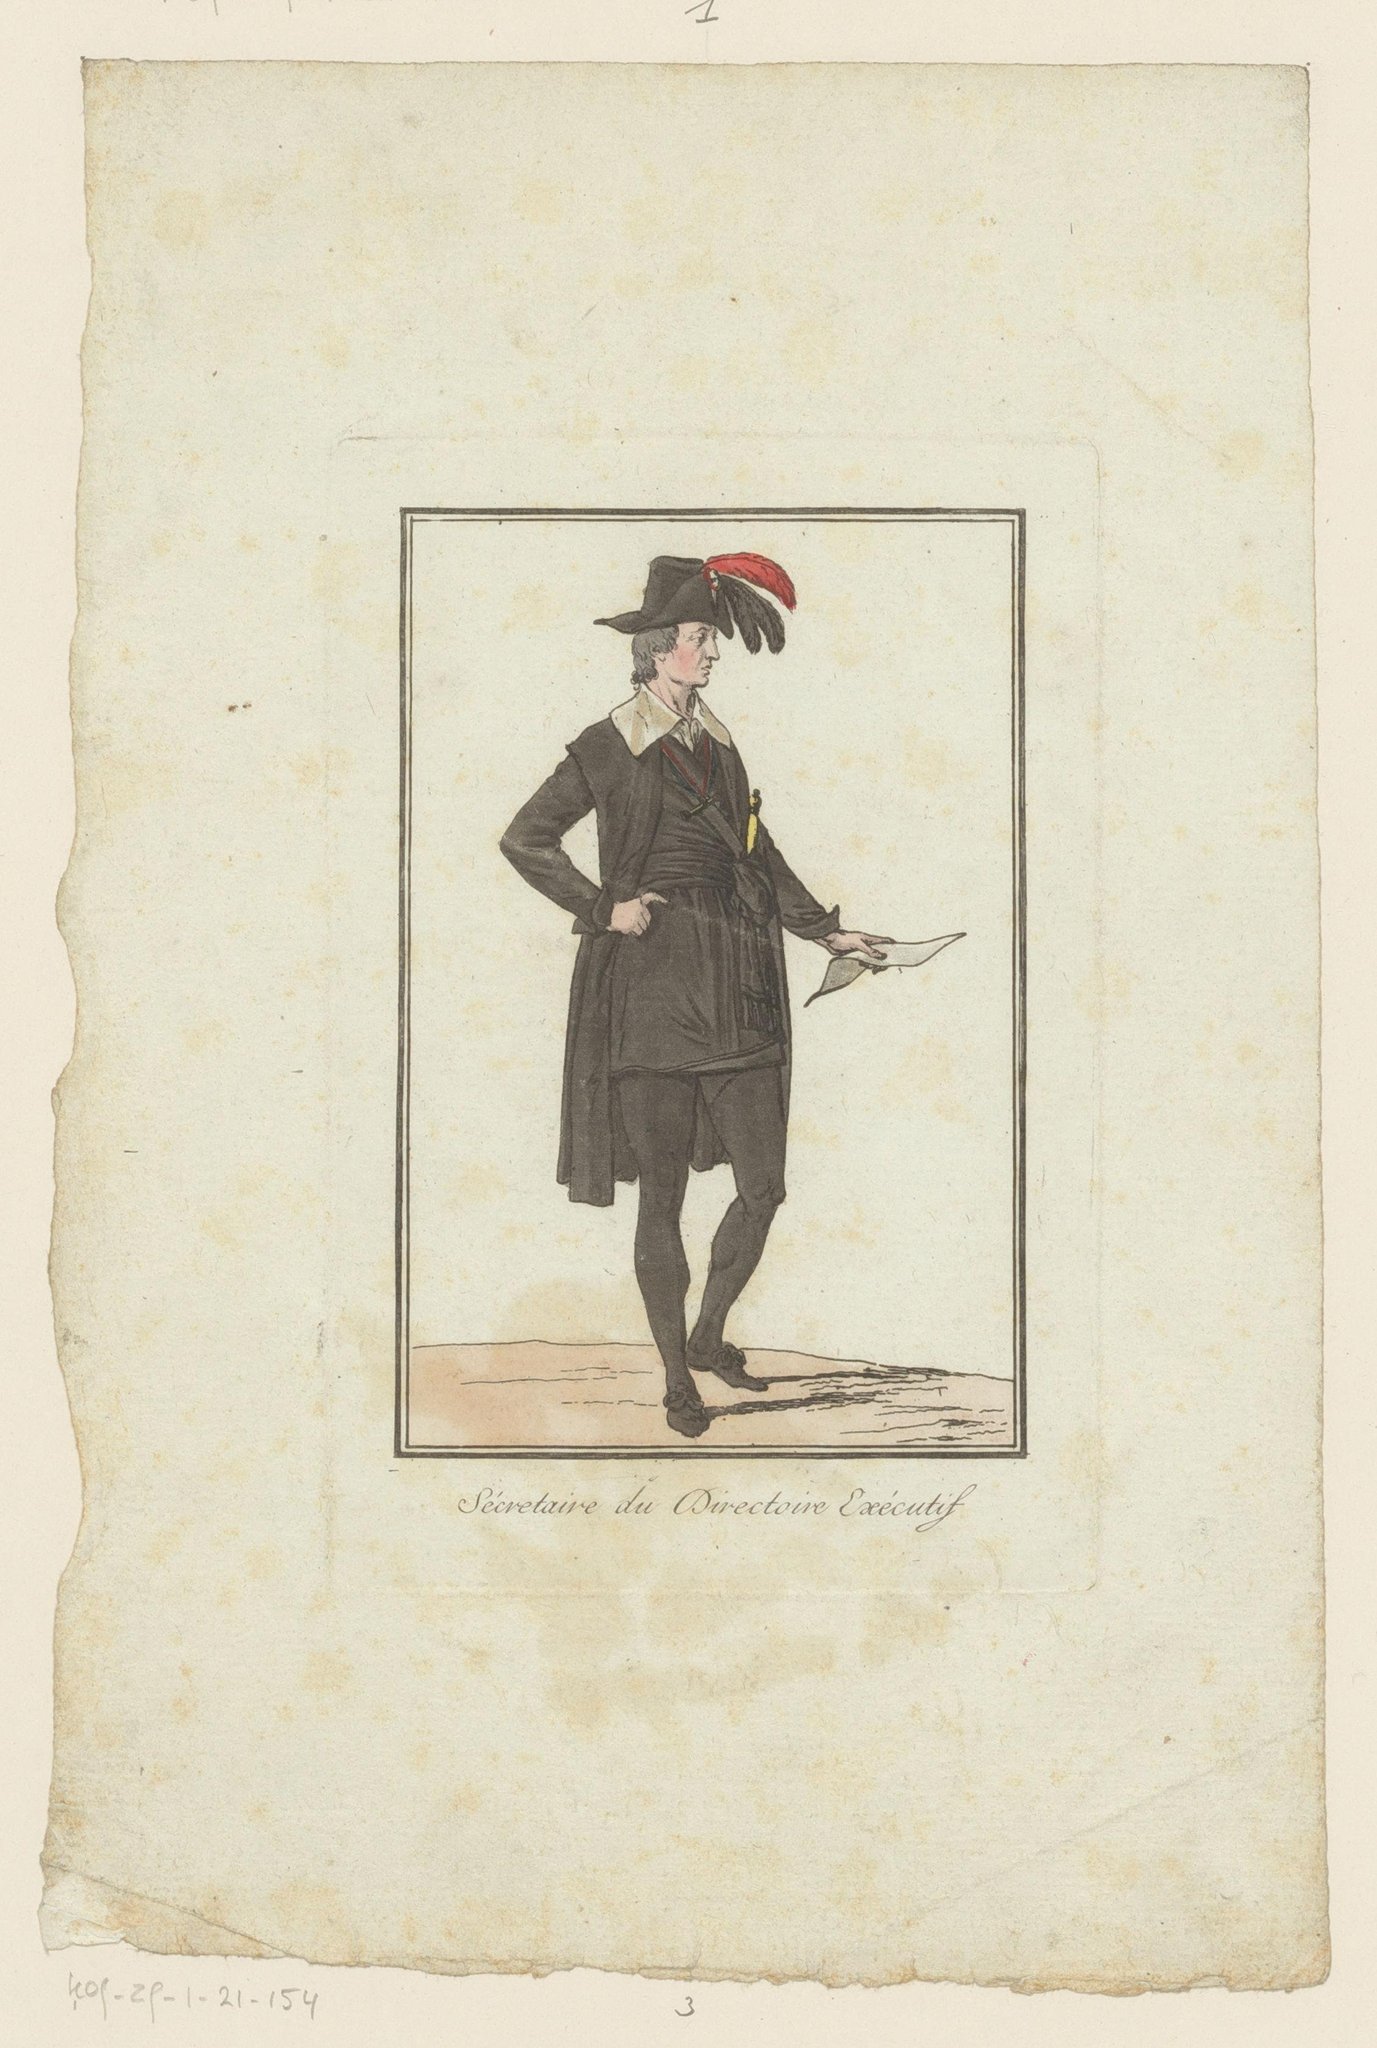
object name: print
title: Sécretaire du Directoire Exécutif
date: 1795-1799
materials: paper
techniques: etching, hand coloring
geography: paris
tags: national government, clothes, costume, head-gear: hat (+ feathers used for clothes)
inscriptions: stamp, collector's mark: Lugt 1641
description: Onderwerpsrubrieken binnen de Atlas Zeden en Gewoonten: Zeden en Gewoonten in Engeren Zin, De Kleeding, Kleederdrachten (tijdvakken), De Fransche Revolutie. (Het Directoire).